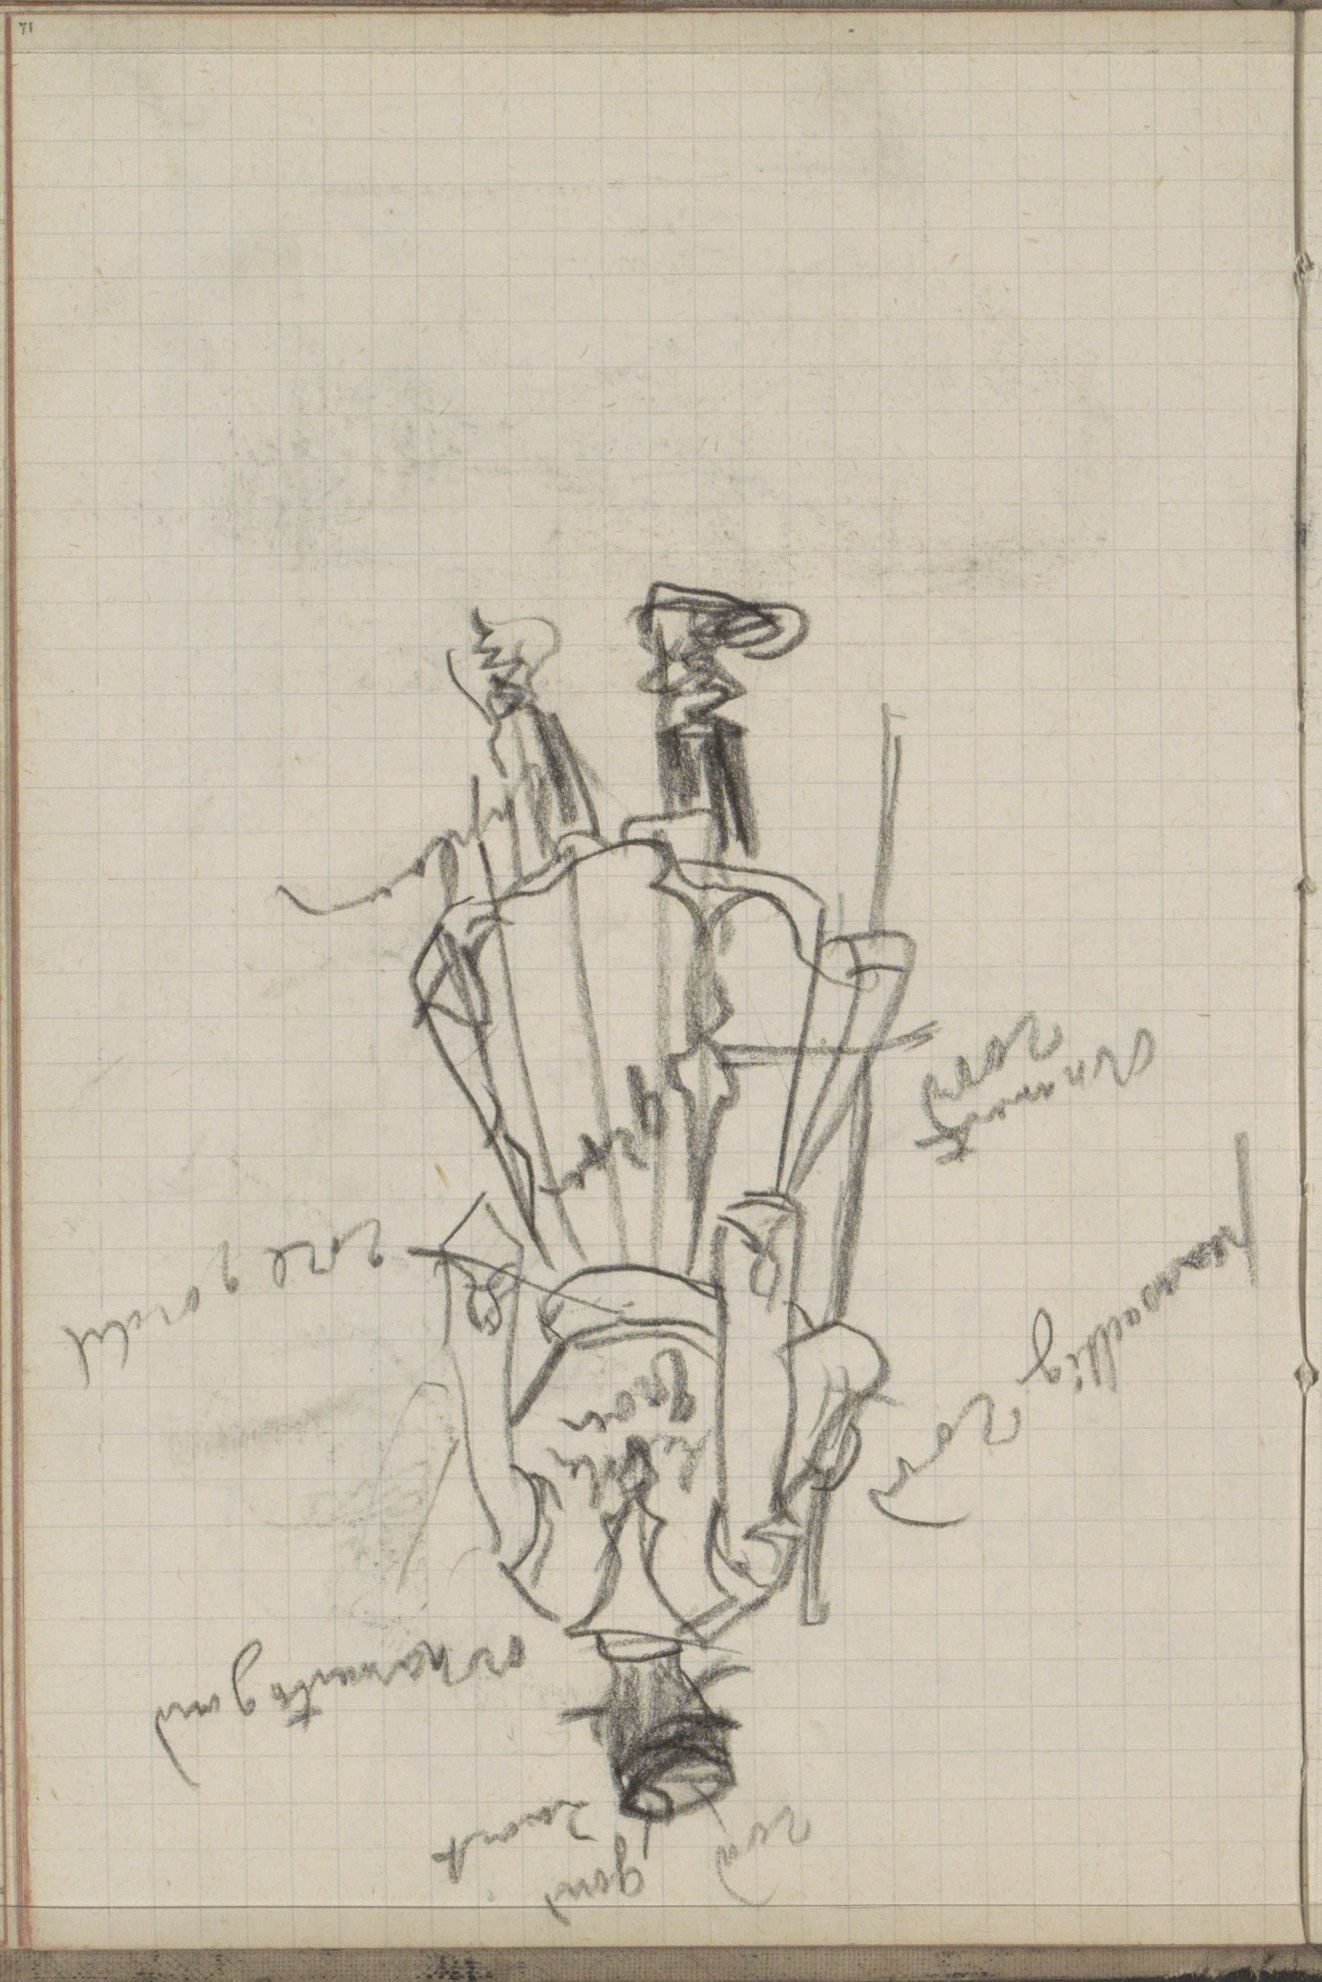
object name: sketchbook leaf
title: Staande figuur met staf in oosterse kleding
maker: marius bauer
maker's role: draughtsman, print maker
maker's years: 1867-1932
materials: chalk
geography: istanbul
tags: asiatic races and peoples, standing figure, walking-stick, staff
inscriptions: kleurnotitie, handgeschreven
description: Van achter gezien. Pagina 71 uit een schetsboek met 54 bladen.